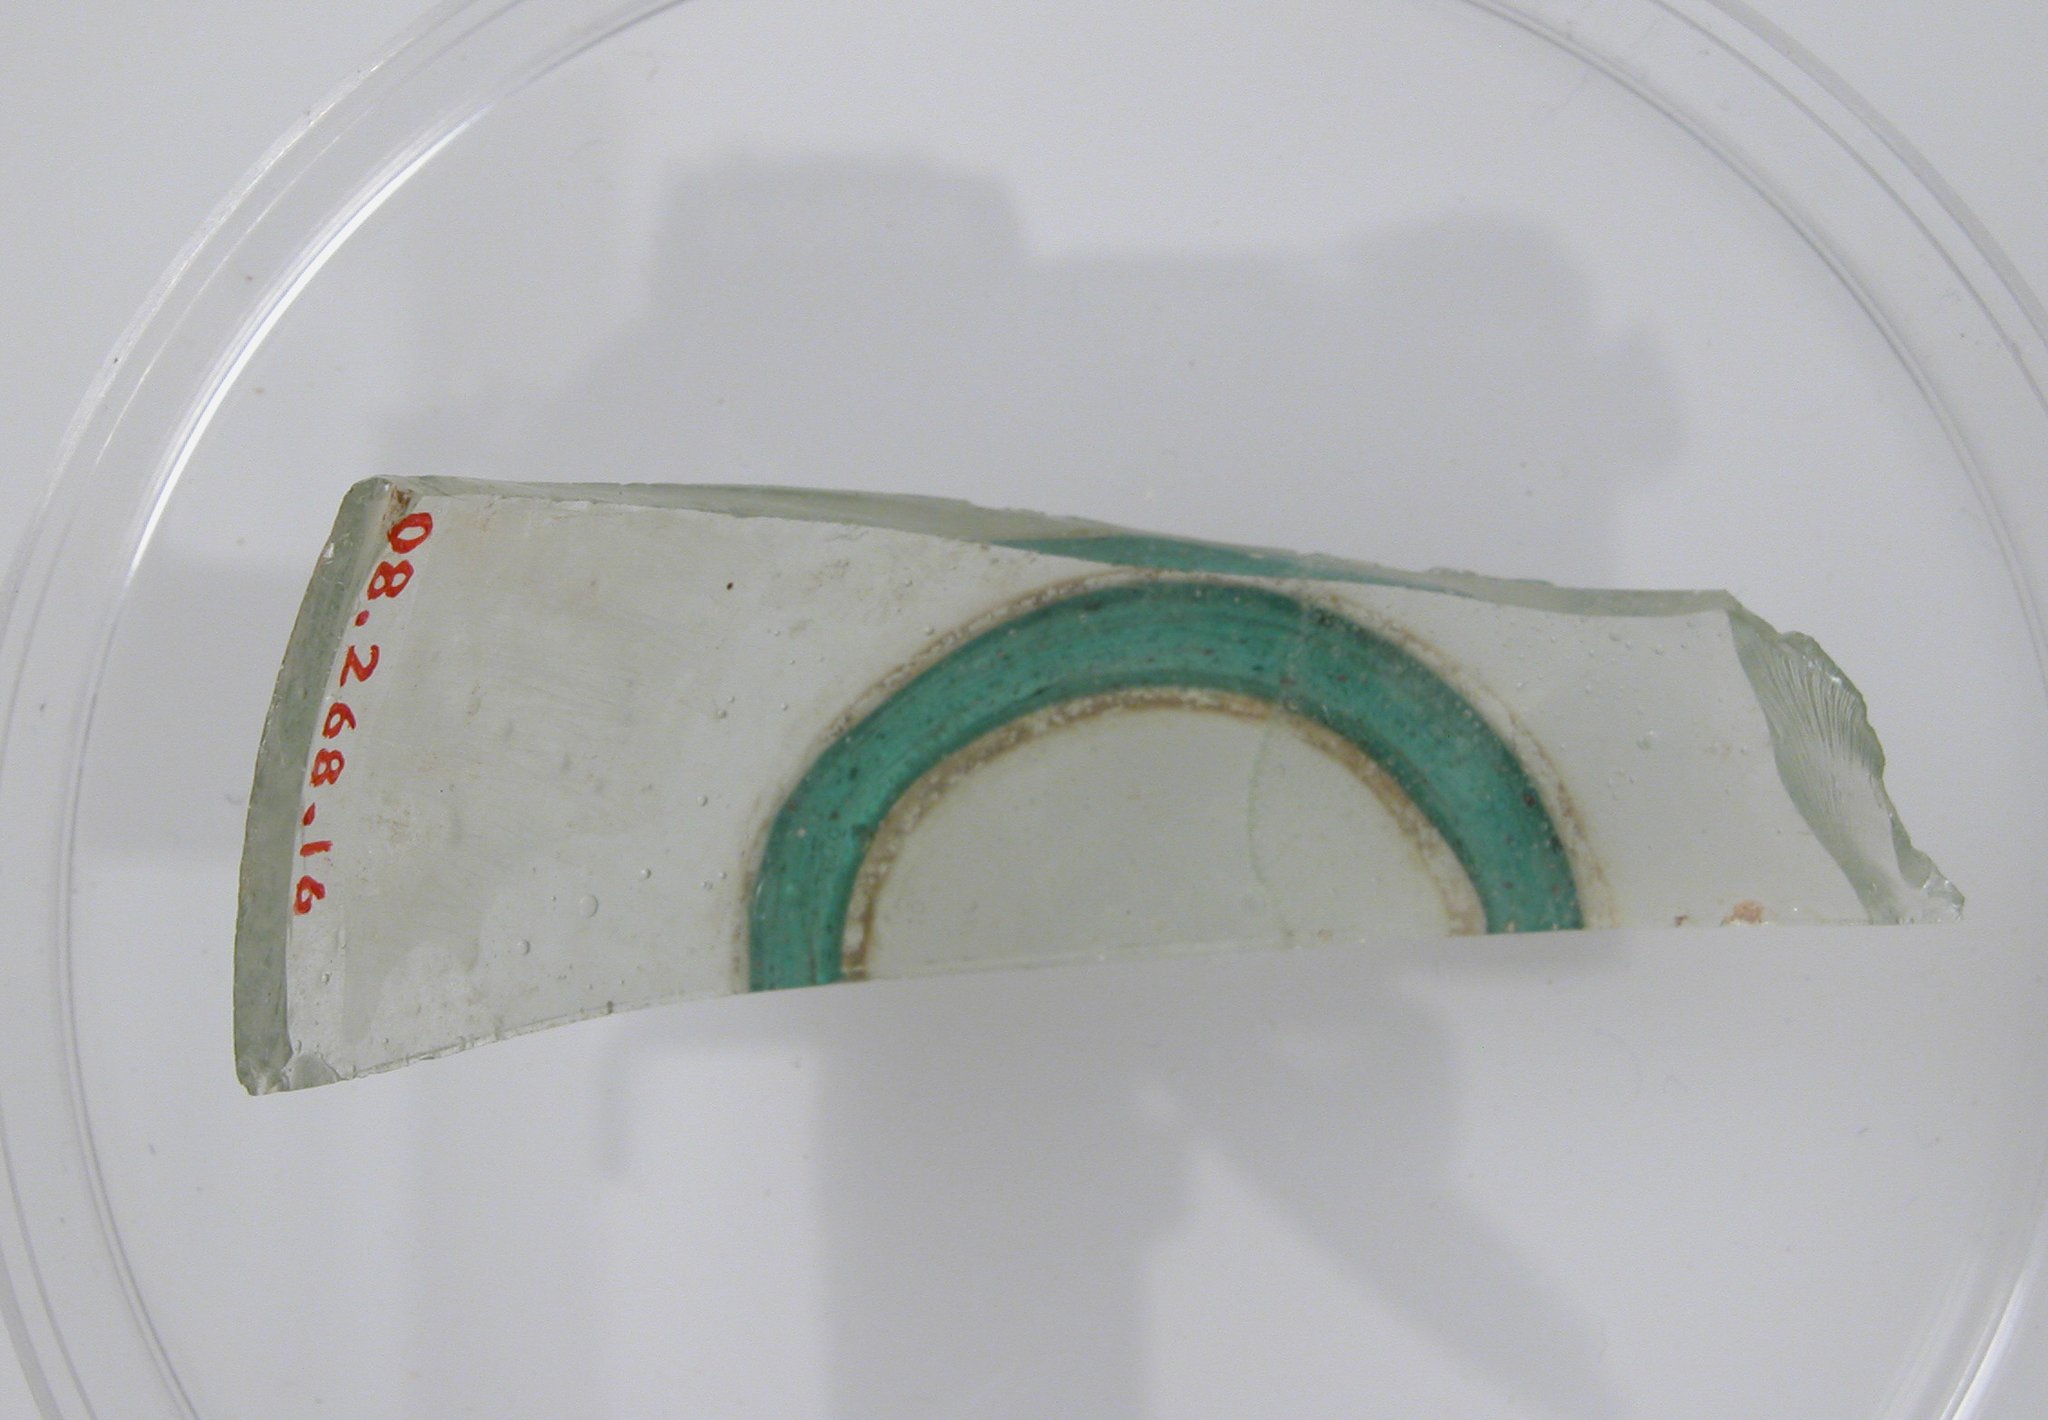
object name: fragment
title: Base and Foot of a Vessel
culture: coptic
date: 301-433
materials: glass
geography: egypt